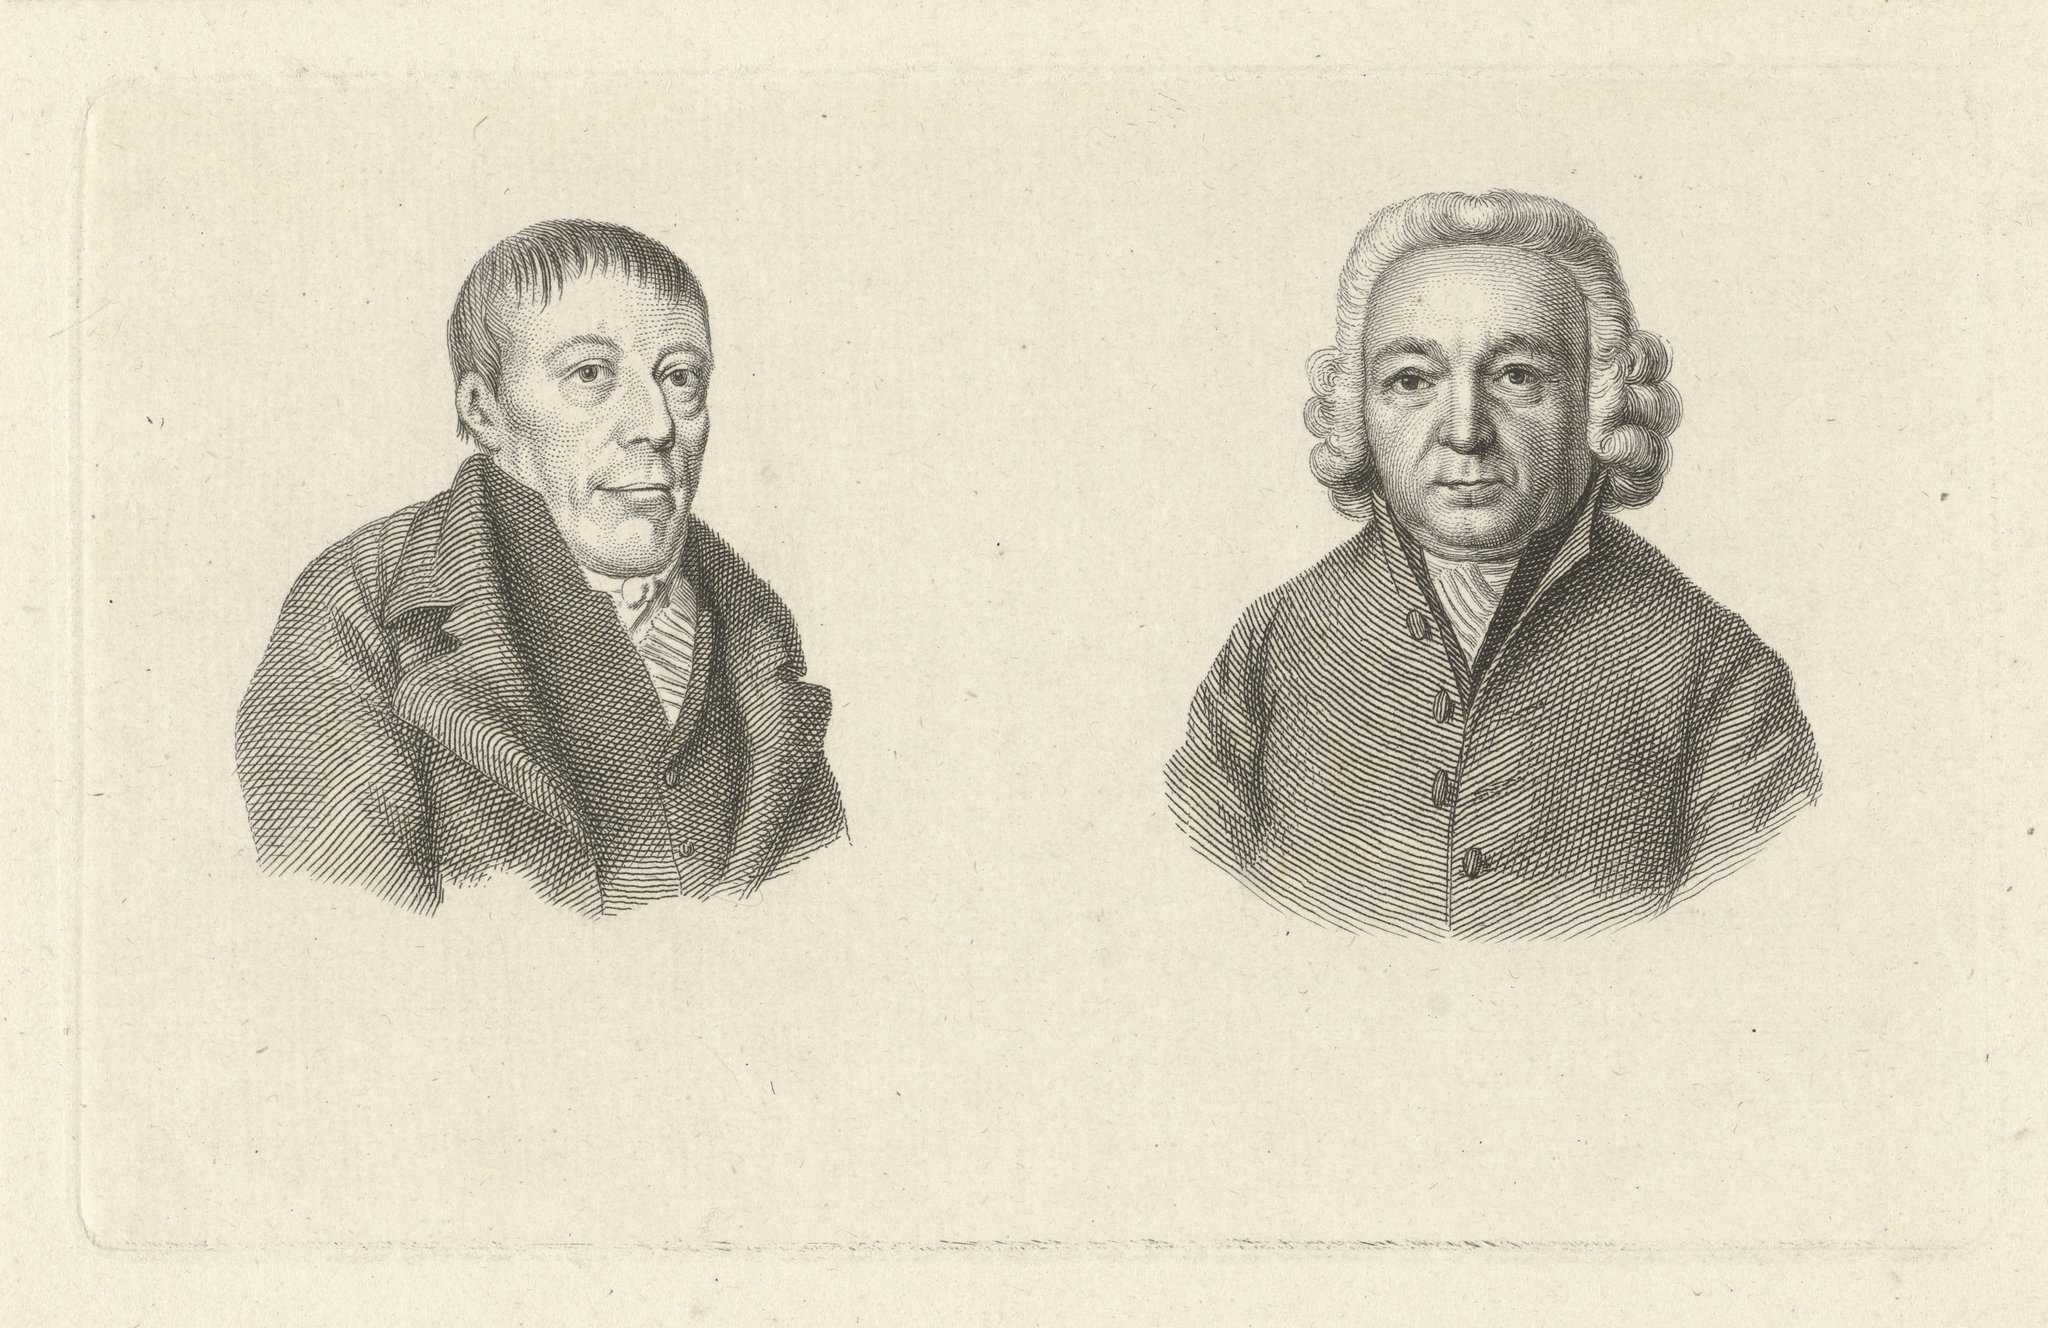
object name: print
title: Portretten van Paulus van Hemert en Jean Henri van Swinden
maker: jacob ernst marcus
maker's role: draughtsman, print maker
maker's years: 1774-1826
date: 1814-1816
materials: paper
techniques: etching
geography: amsterdam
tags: physicist, jean henri van swinden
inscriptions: collector's mark: Lugt 2228, :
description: Serie voor het eerst uitgegeven door Jacob Ernst Marcus onder de titel Studiebeelden en Fragmenten. Amsterdam: ca.1816. Later heruitgegeven als: Studie-prentwerk/ Etudes gravées.